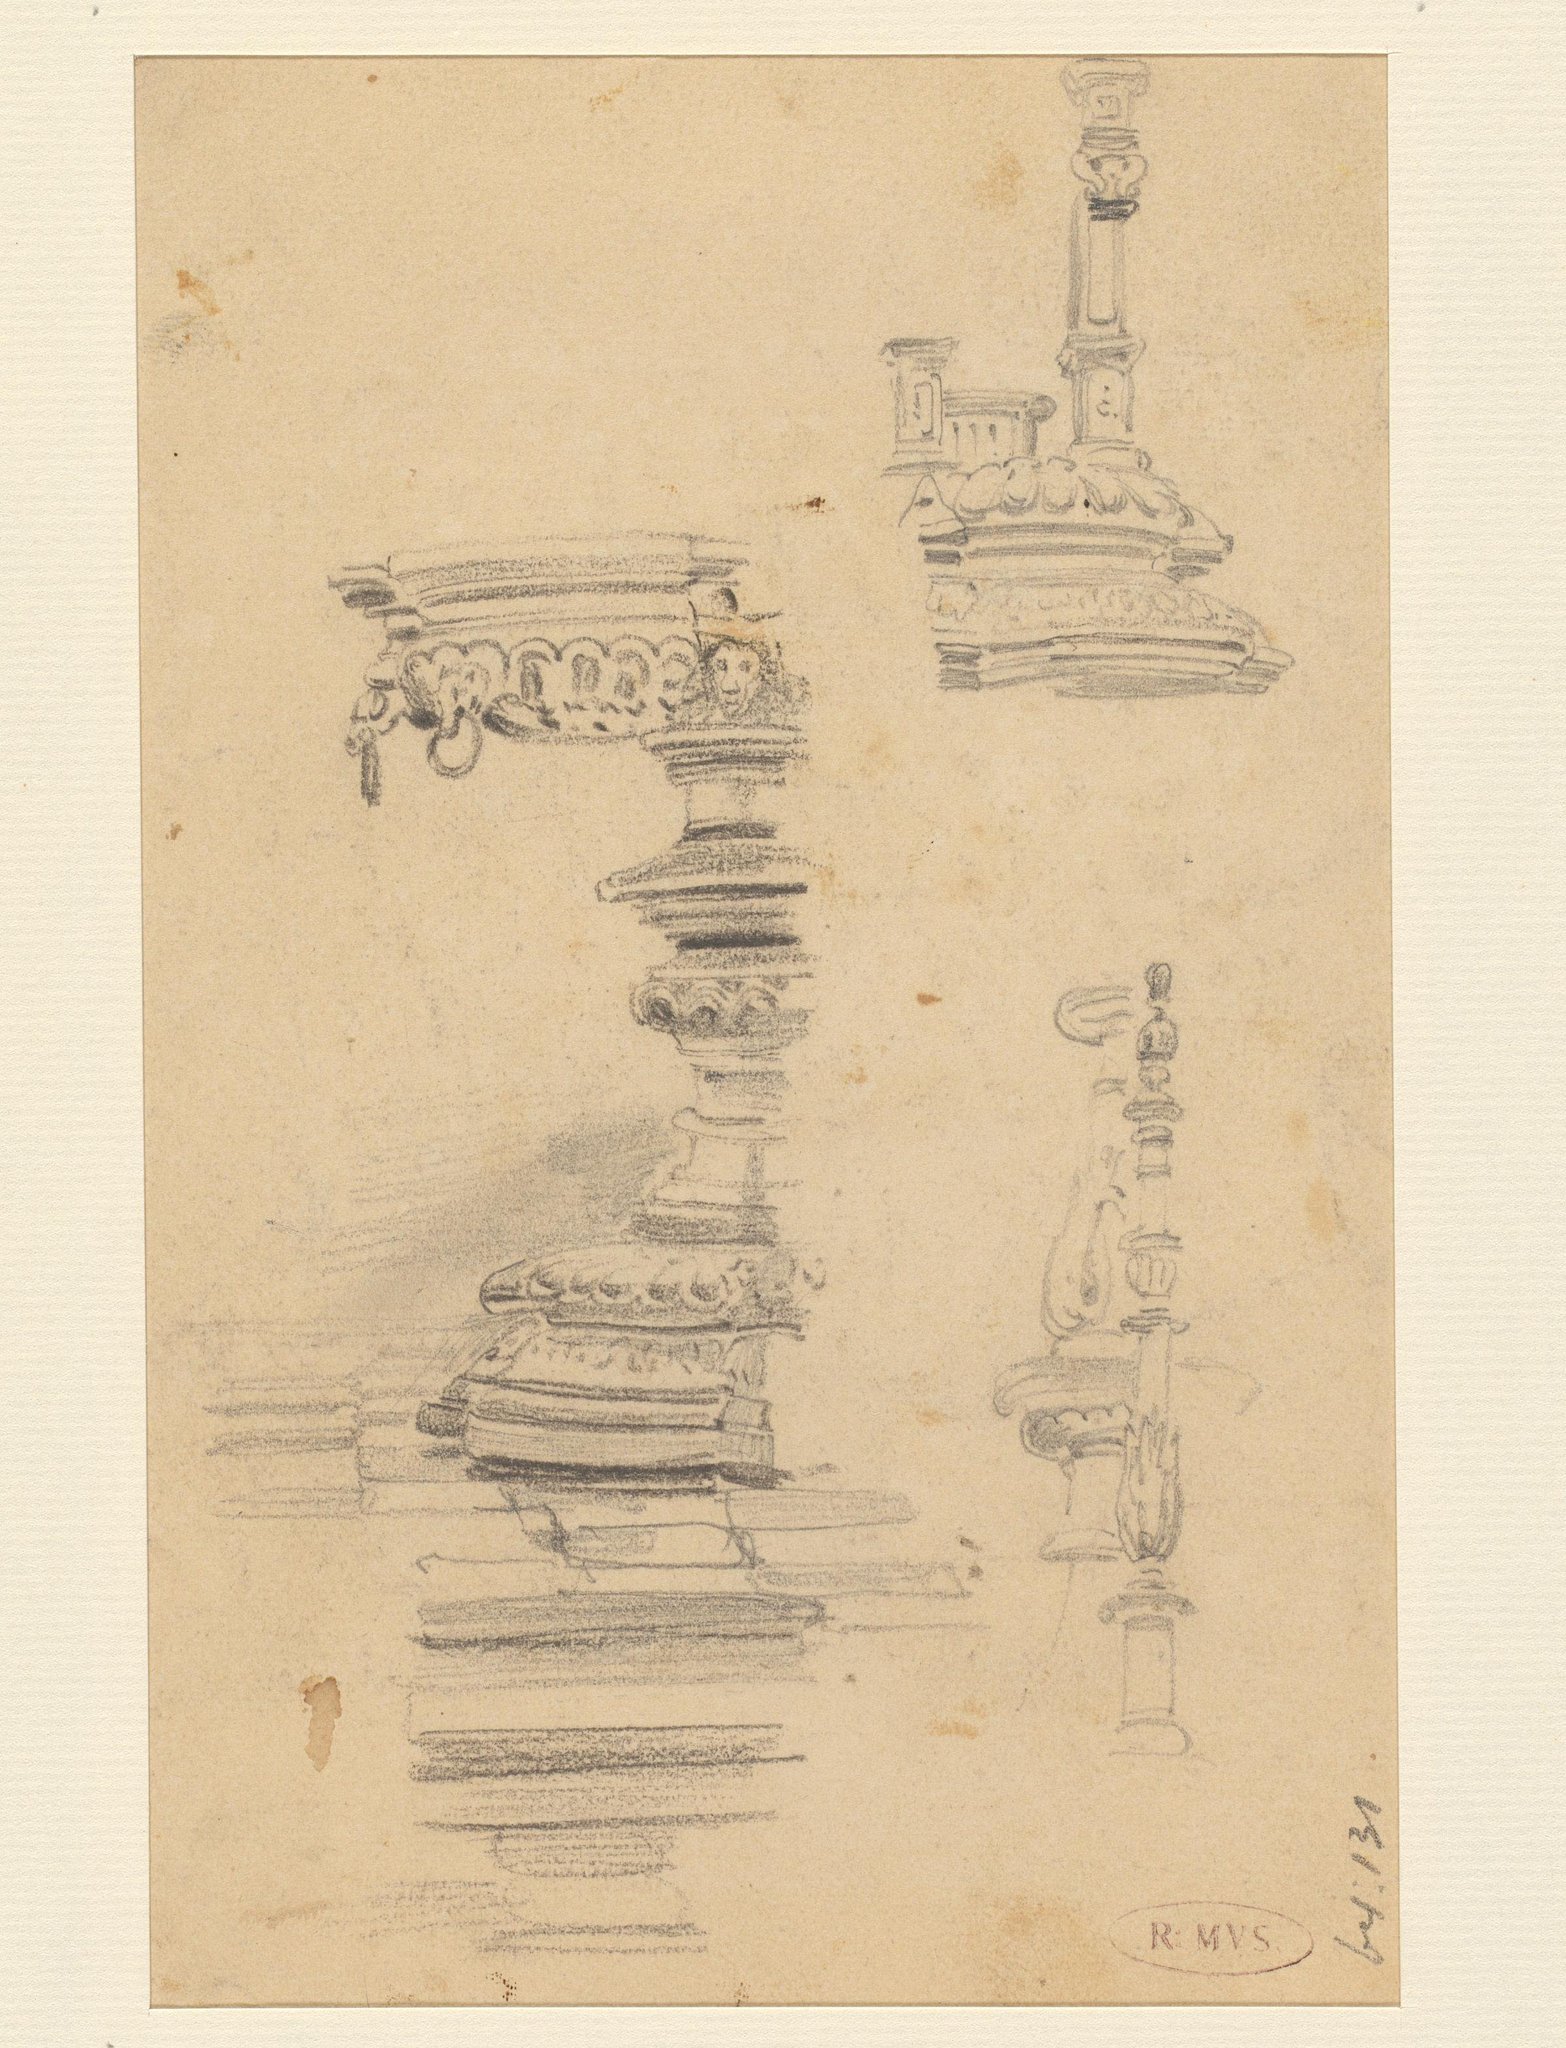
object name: drawing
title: Studies van een doopvont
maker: johannes bosboom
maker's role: draughtsman, painter, print maker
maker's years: 1817-1891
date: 1827-1891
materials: chalk, paper, pencil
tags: baptismal font